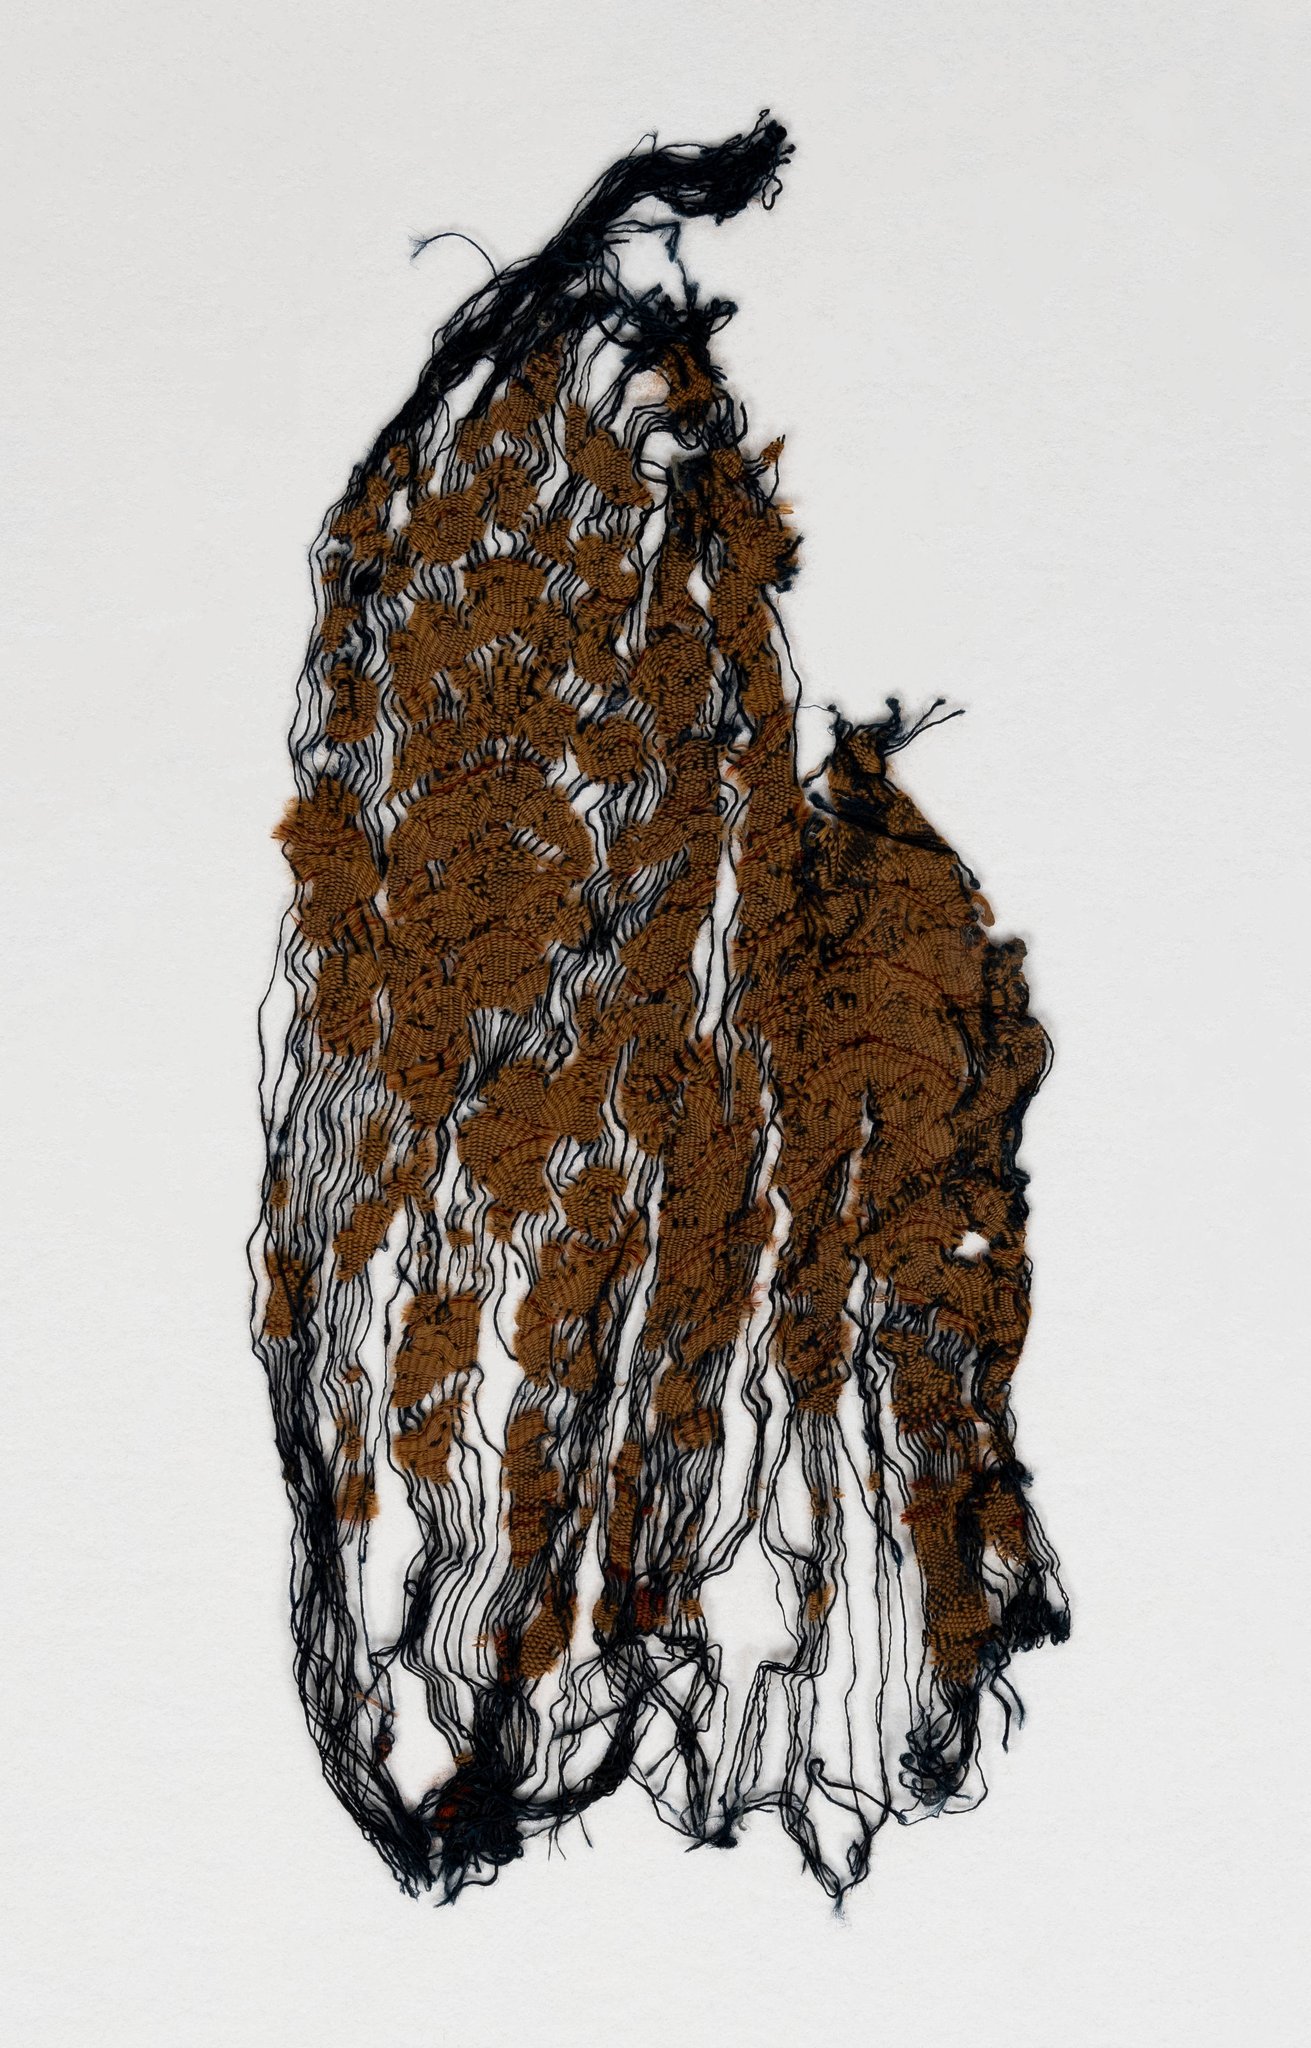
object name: textile fragment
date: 1101-1200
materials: silk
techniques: tapestry, weave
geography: egypt